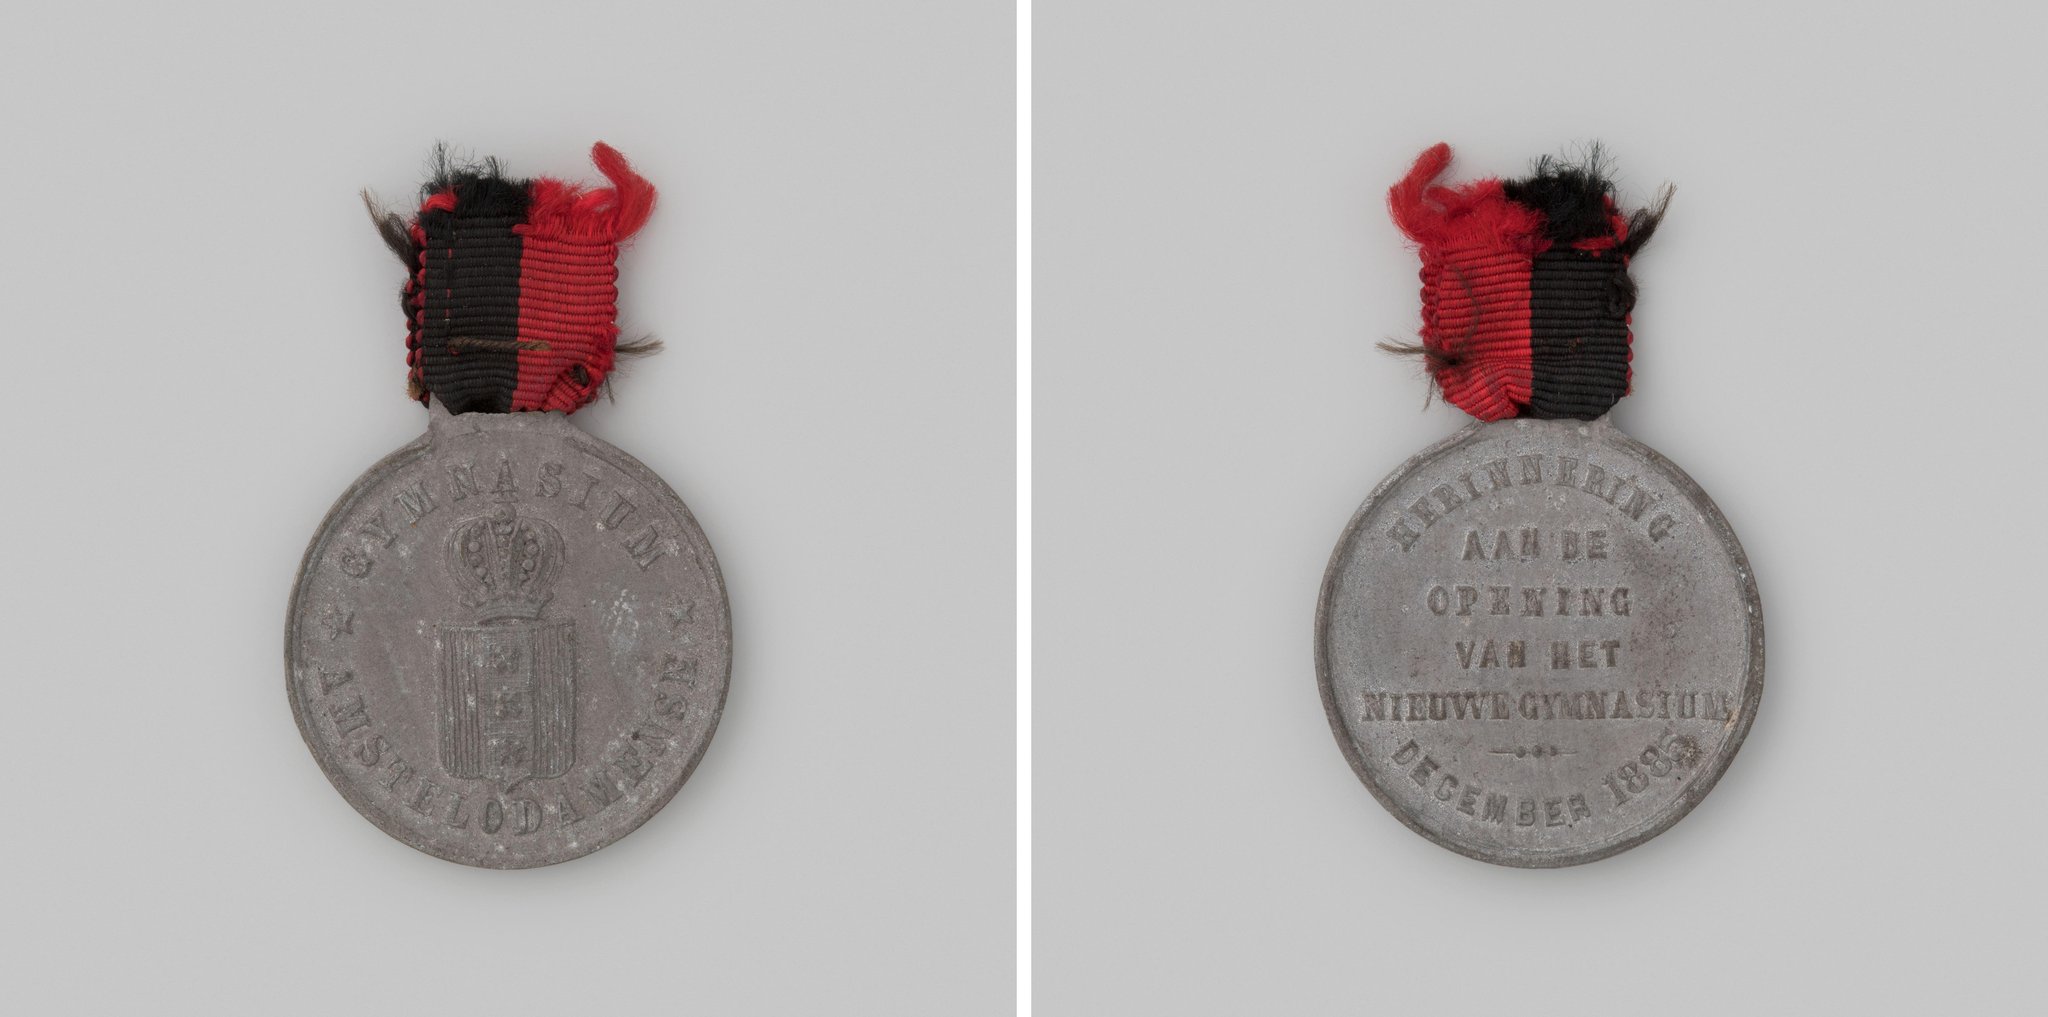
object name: history medal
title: Opening van het nieuwe Gymnasium te Amsterdam 1885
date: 1885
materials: tin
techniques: striking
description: Tinnen penning met breed draagoog aan kort rood-zwart lint, op de voorzijde het gekroonde Amsterdamse wapenschild met omschrift, op de keerzijde zes regels tekst.